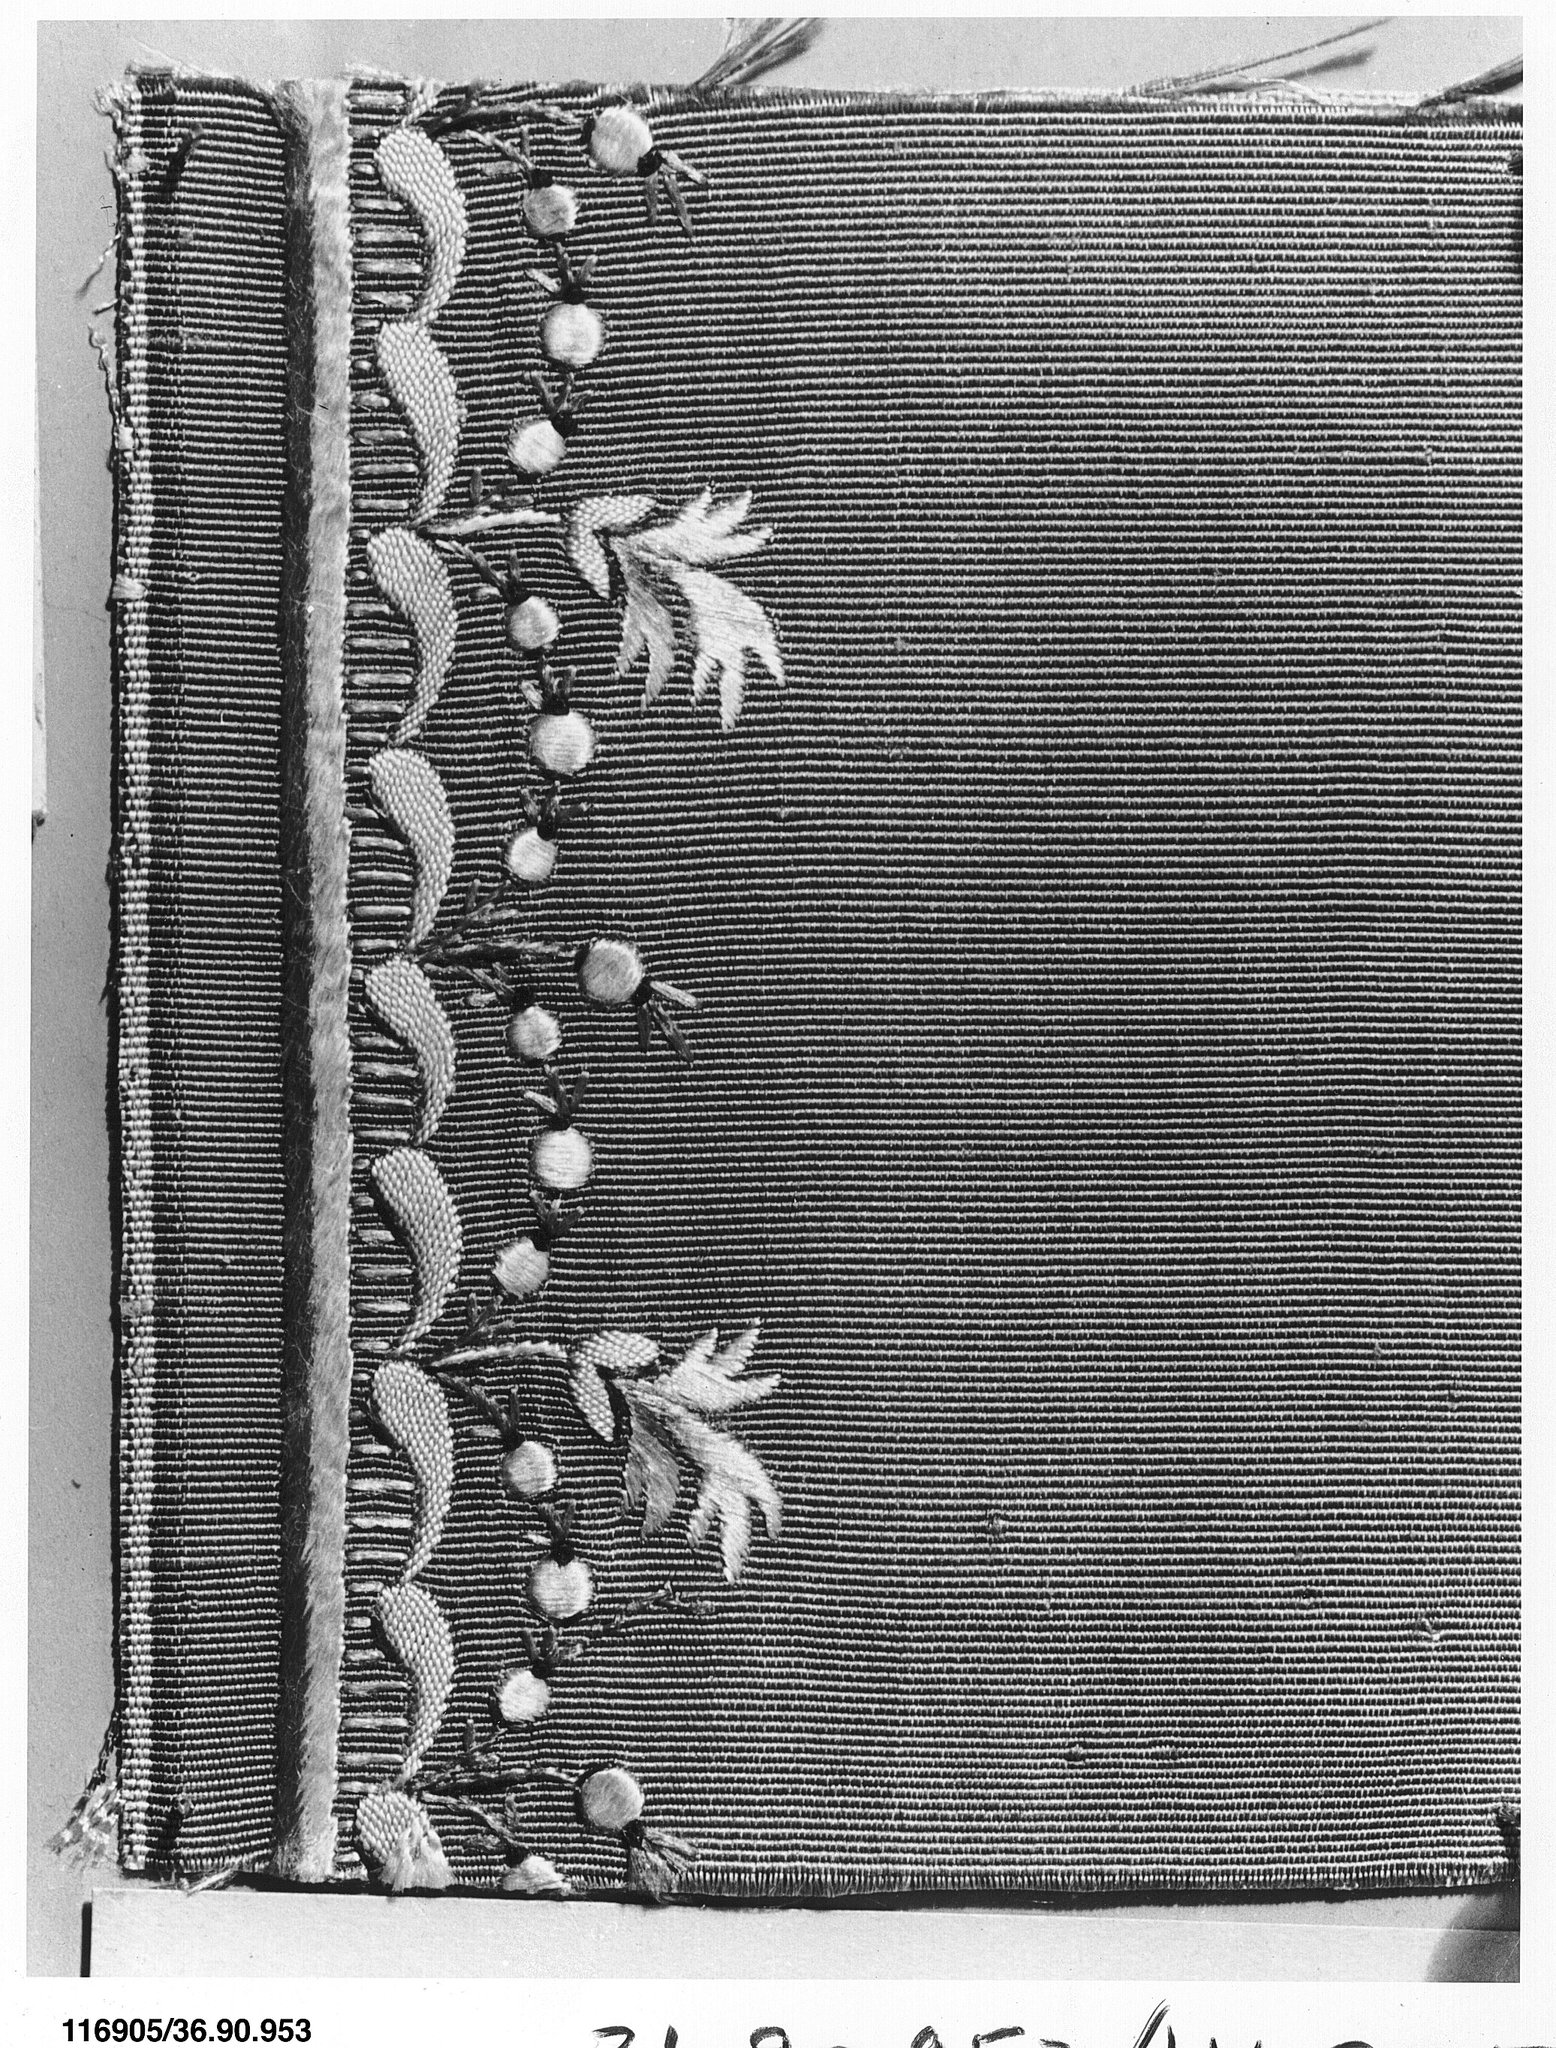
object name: sample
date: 1801-1833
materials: silk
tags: flowers